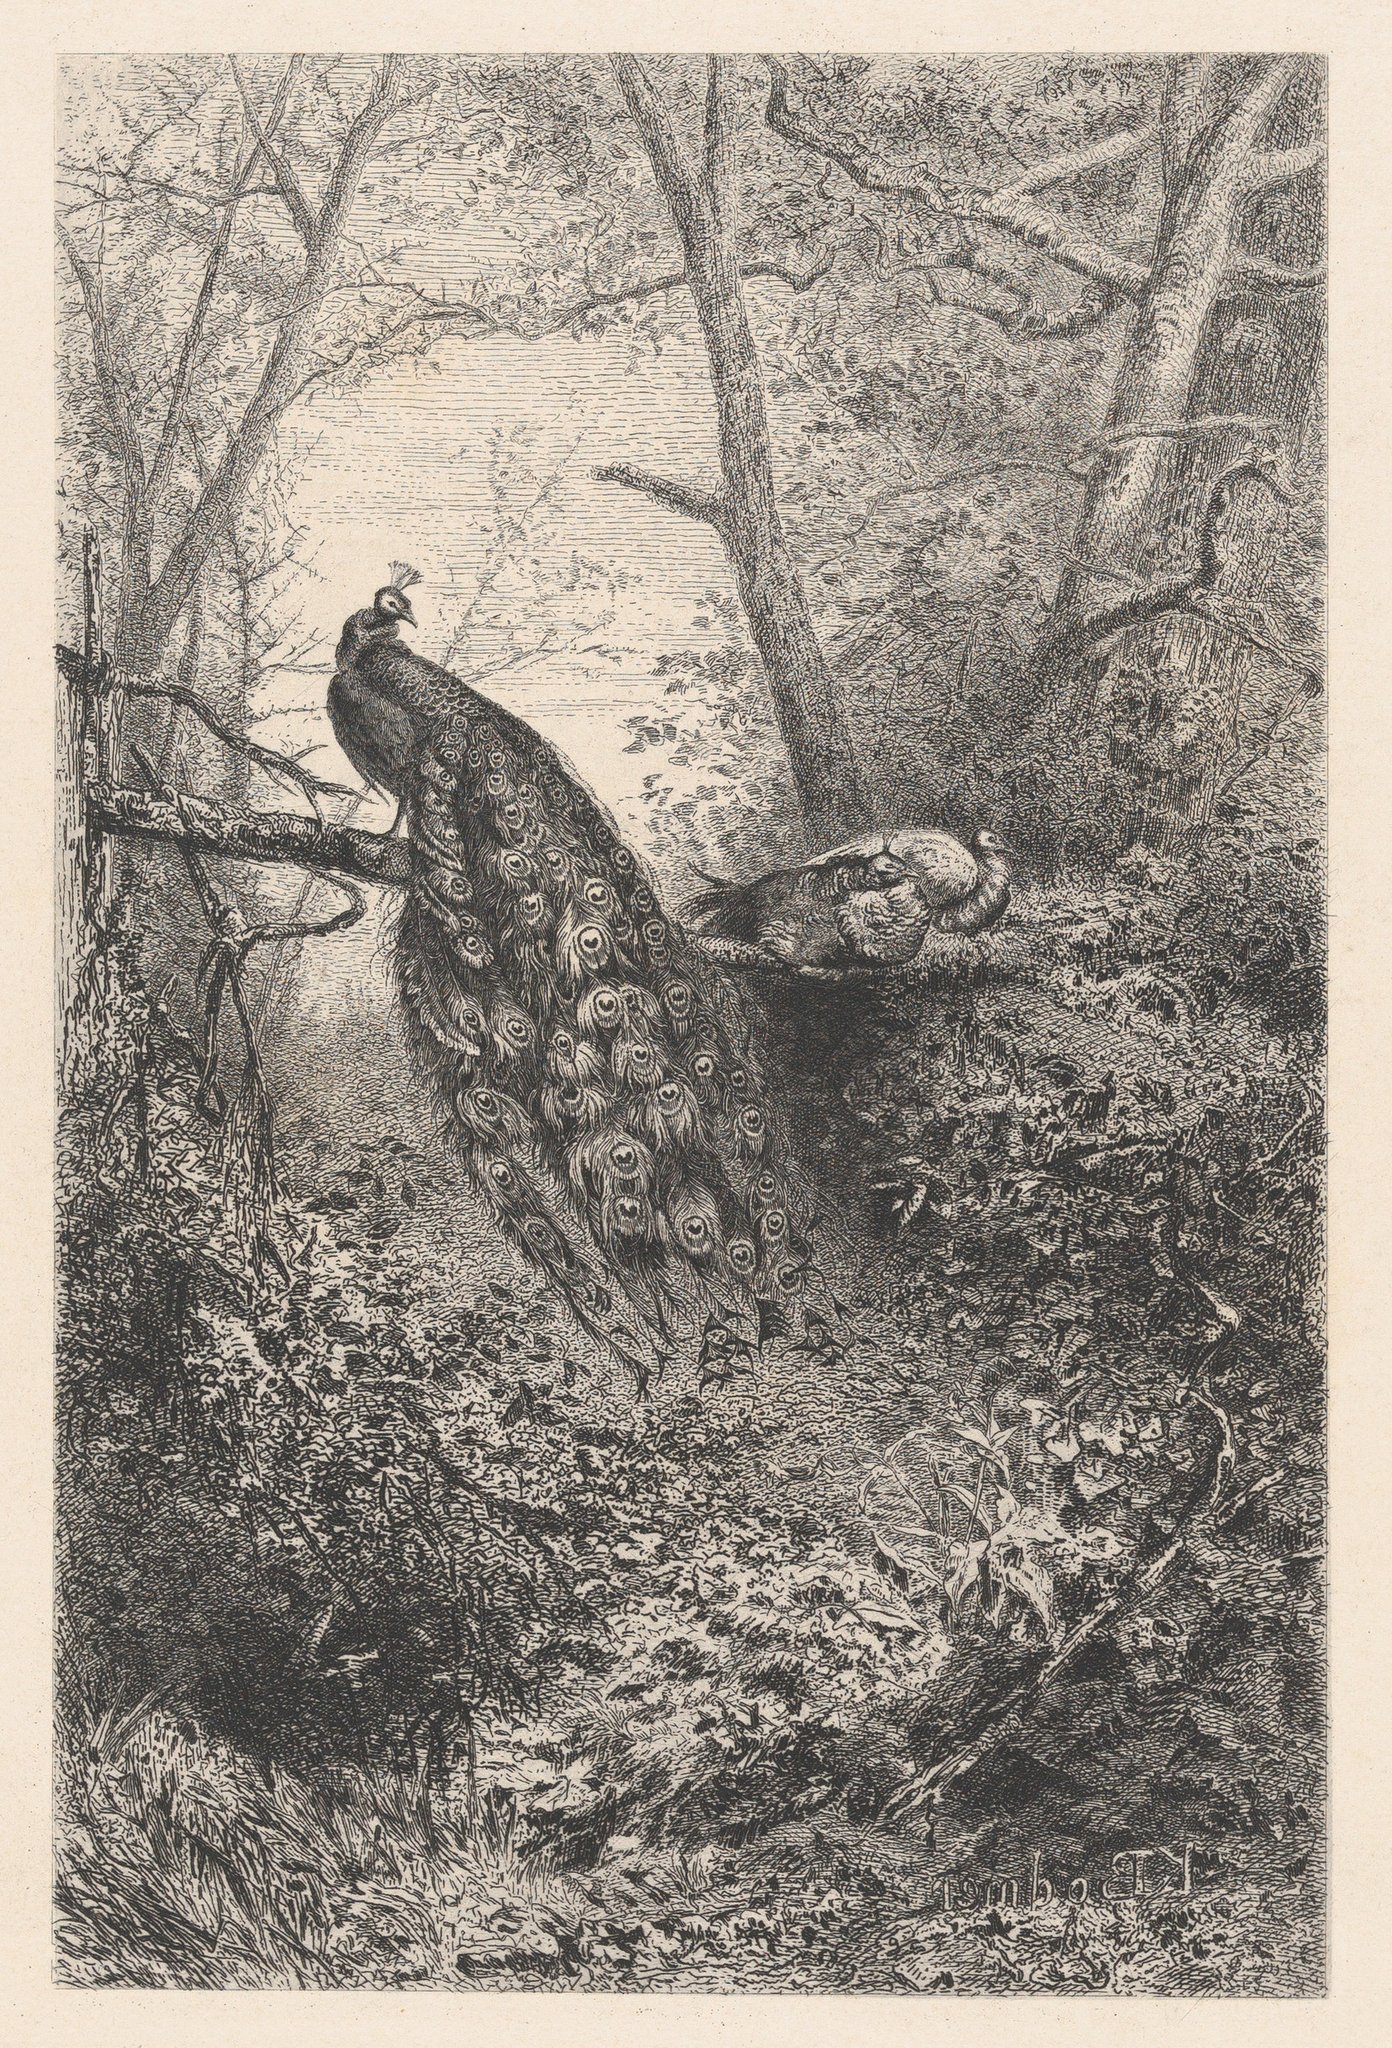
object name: print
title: Peacocks on a Branch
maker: karl bodmer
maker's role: artist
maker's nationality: swiss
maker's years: 1809-1893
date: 1860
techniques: etching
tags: peacocks